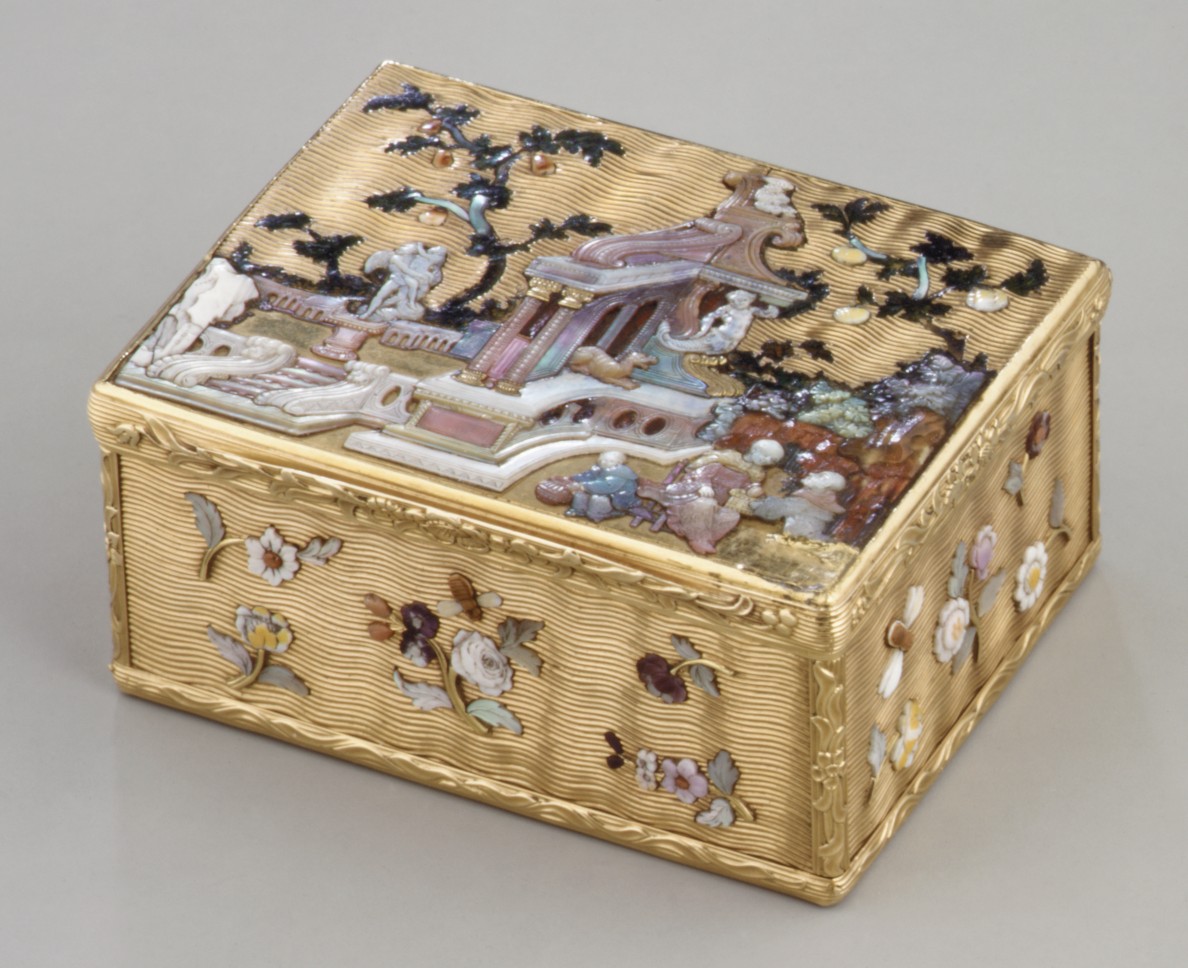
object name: snuffbox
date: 1750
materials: enamel, gold, mother of pearl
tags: human figures,houses,flowers,trees